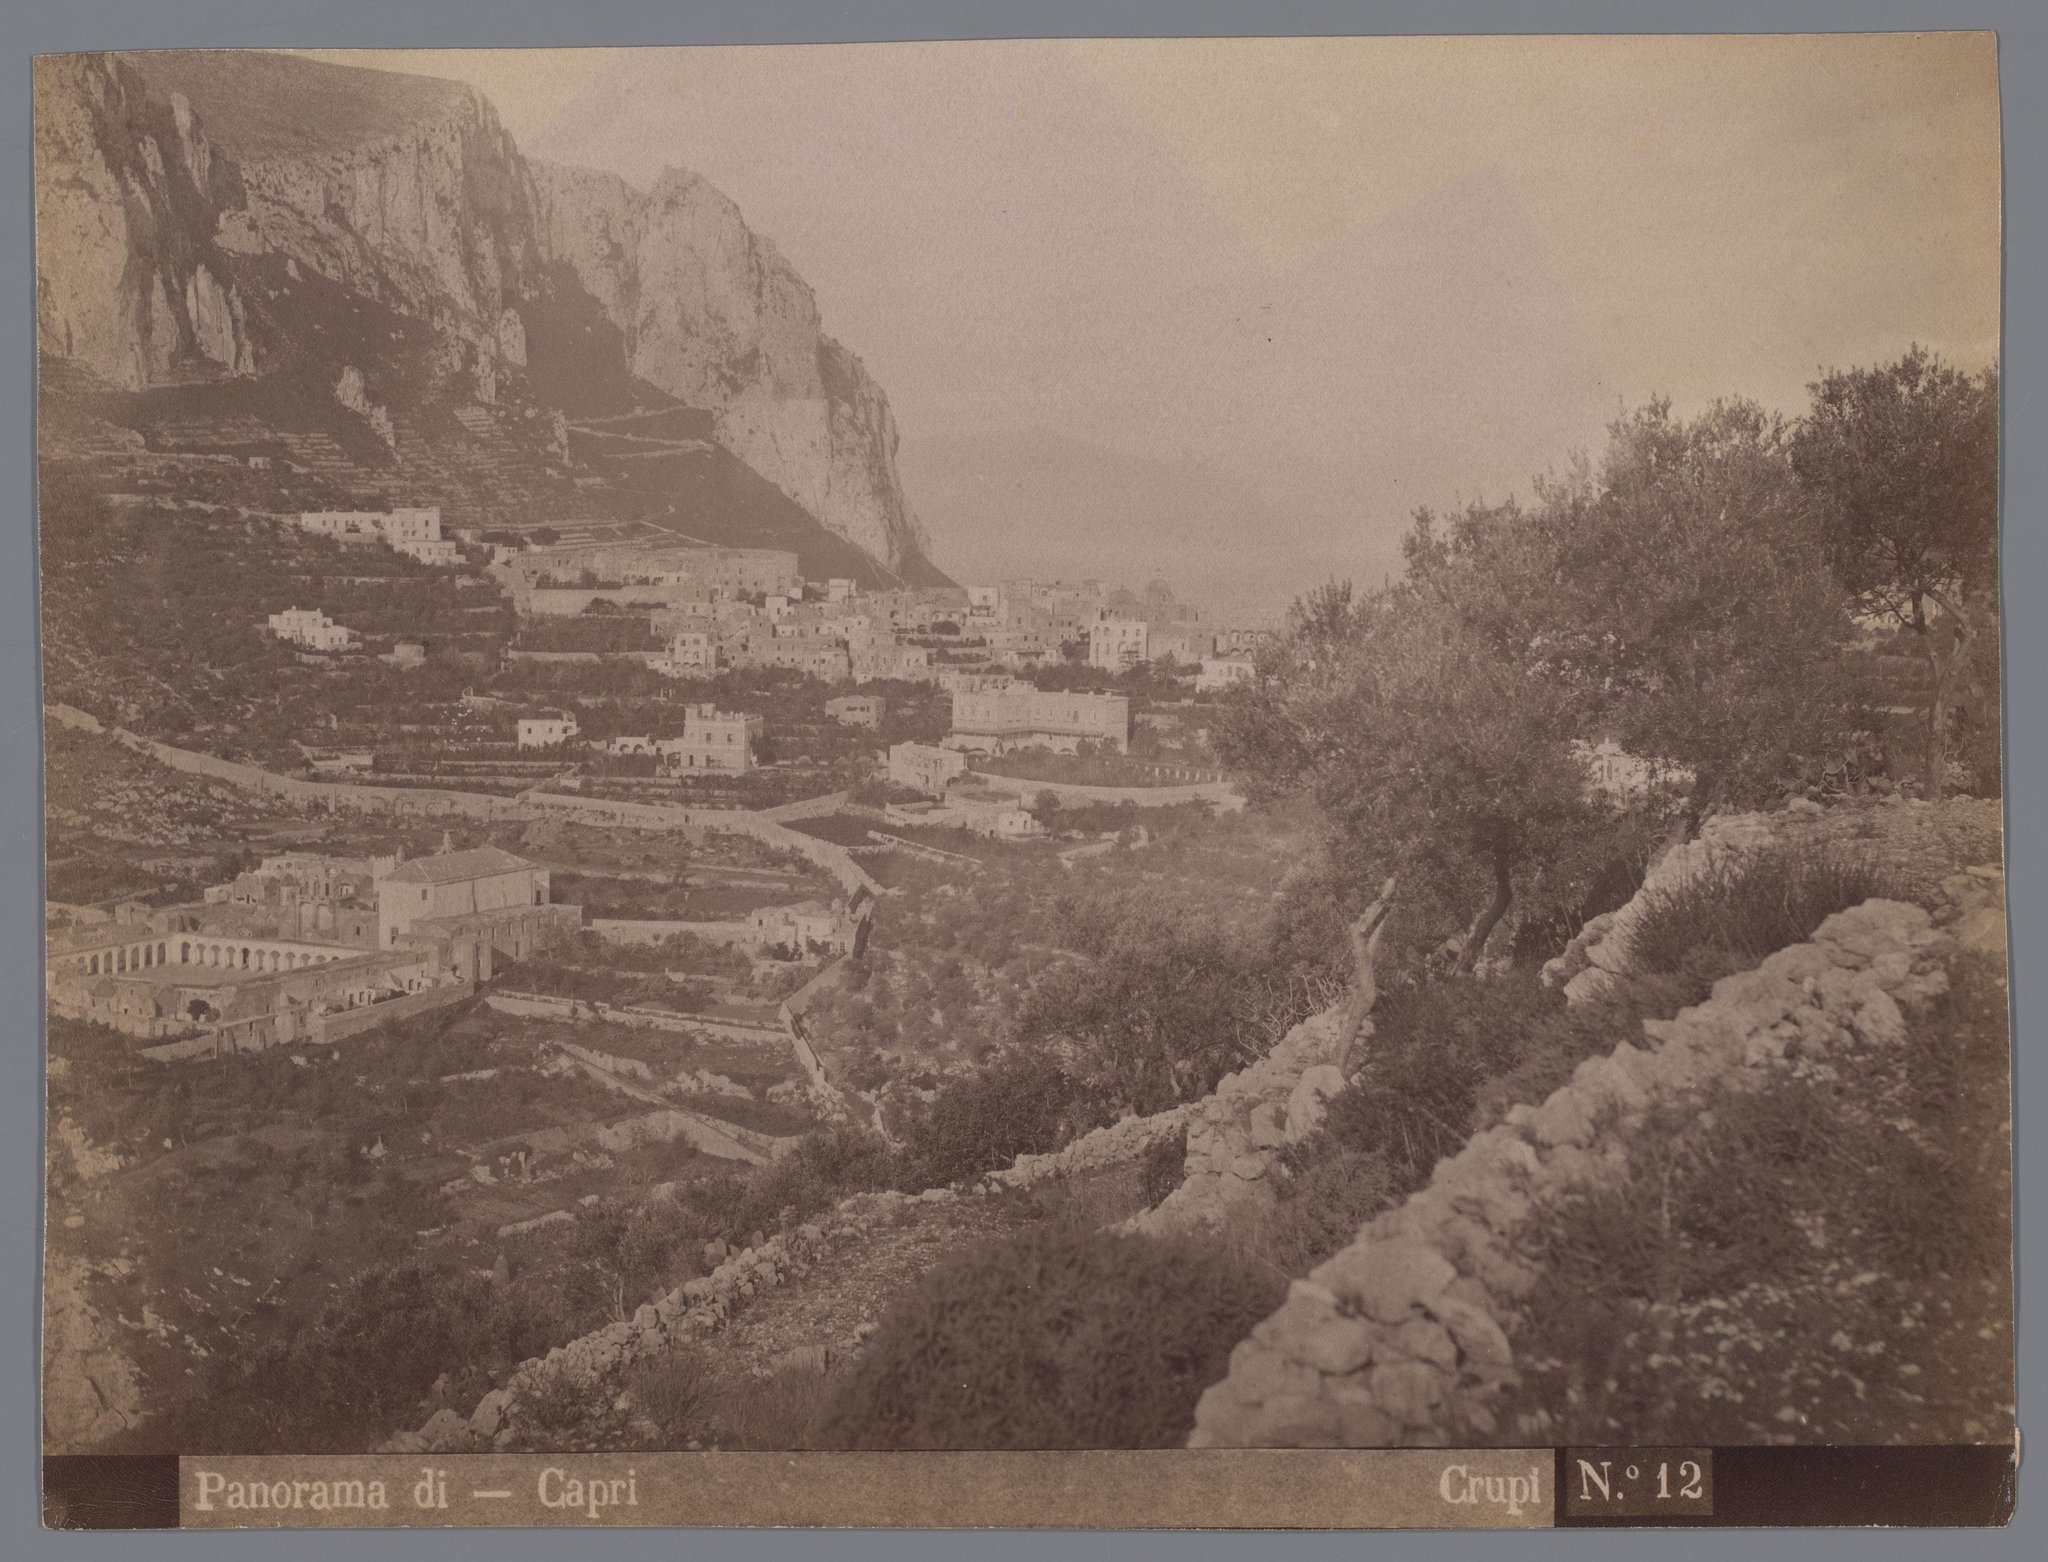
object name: photograph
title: Panorama di Capri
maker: giovanni crupi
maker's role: fotograaf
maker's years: 1859-1925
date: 1865-1875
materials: paper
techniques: albumen print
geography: capri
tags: city-view in general; 'veduta', capri, isola di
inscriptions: number: ‘No. 12’